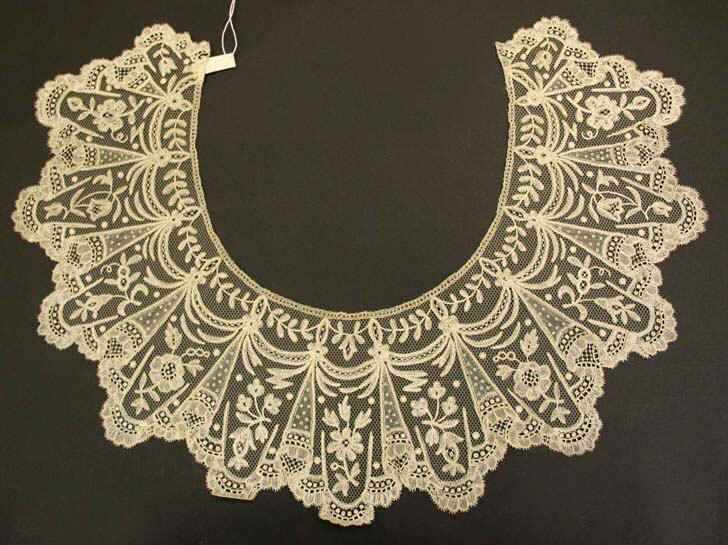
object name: collar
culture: belgian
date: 1834-1866